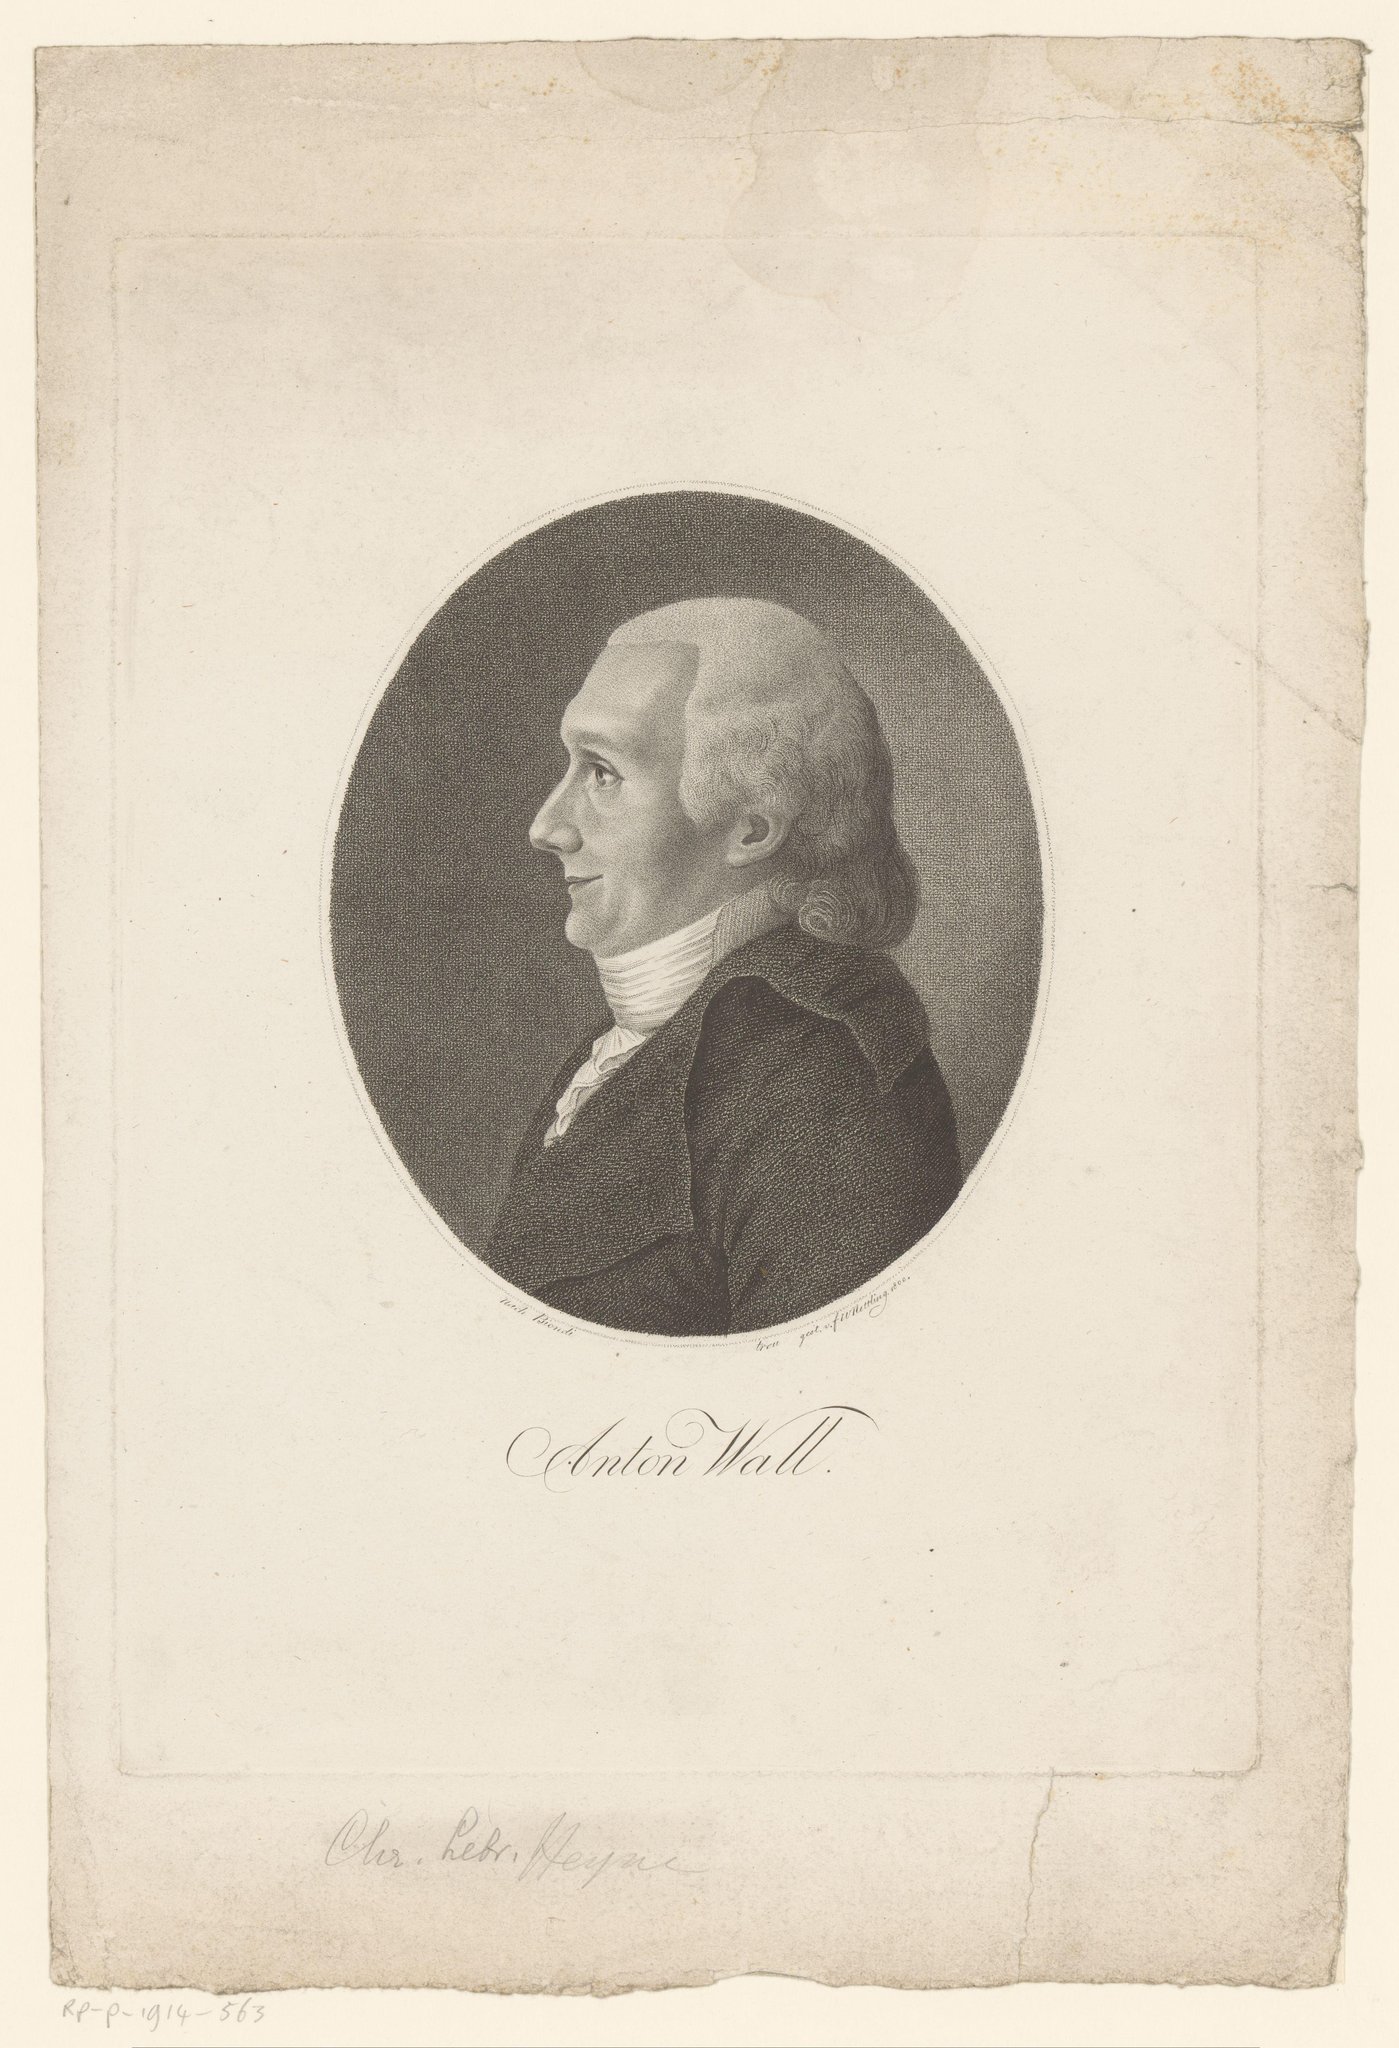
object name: print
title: Portret van Christian Leberecht Heyne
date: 1800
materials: paper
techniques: engraving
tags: historical persons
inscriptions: collector's mark: Lugt 2228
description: Geportretteerde ook bekend onder het pseudoniem Anton Wall. Buste naar links, in ovaal, tegen zwarte achtergrond.